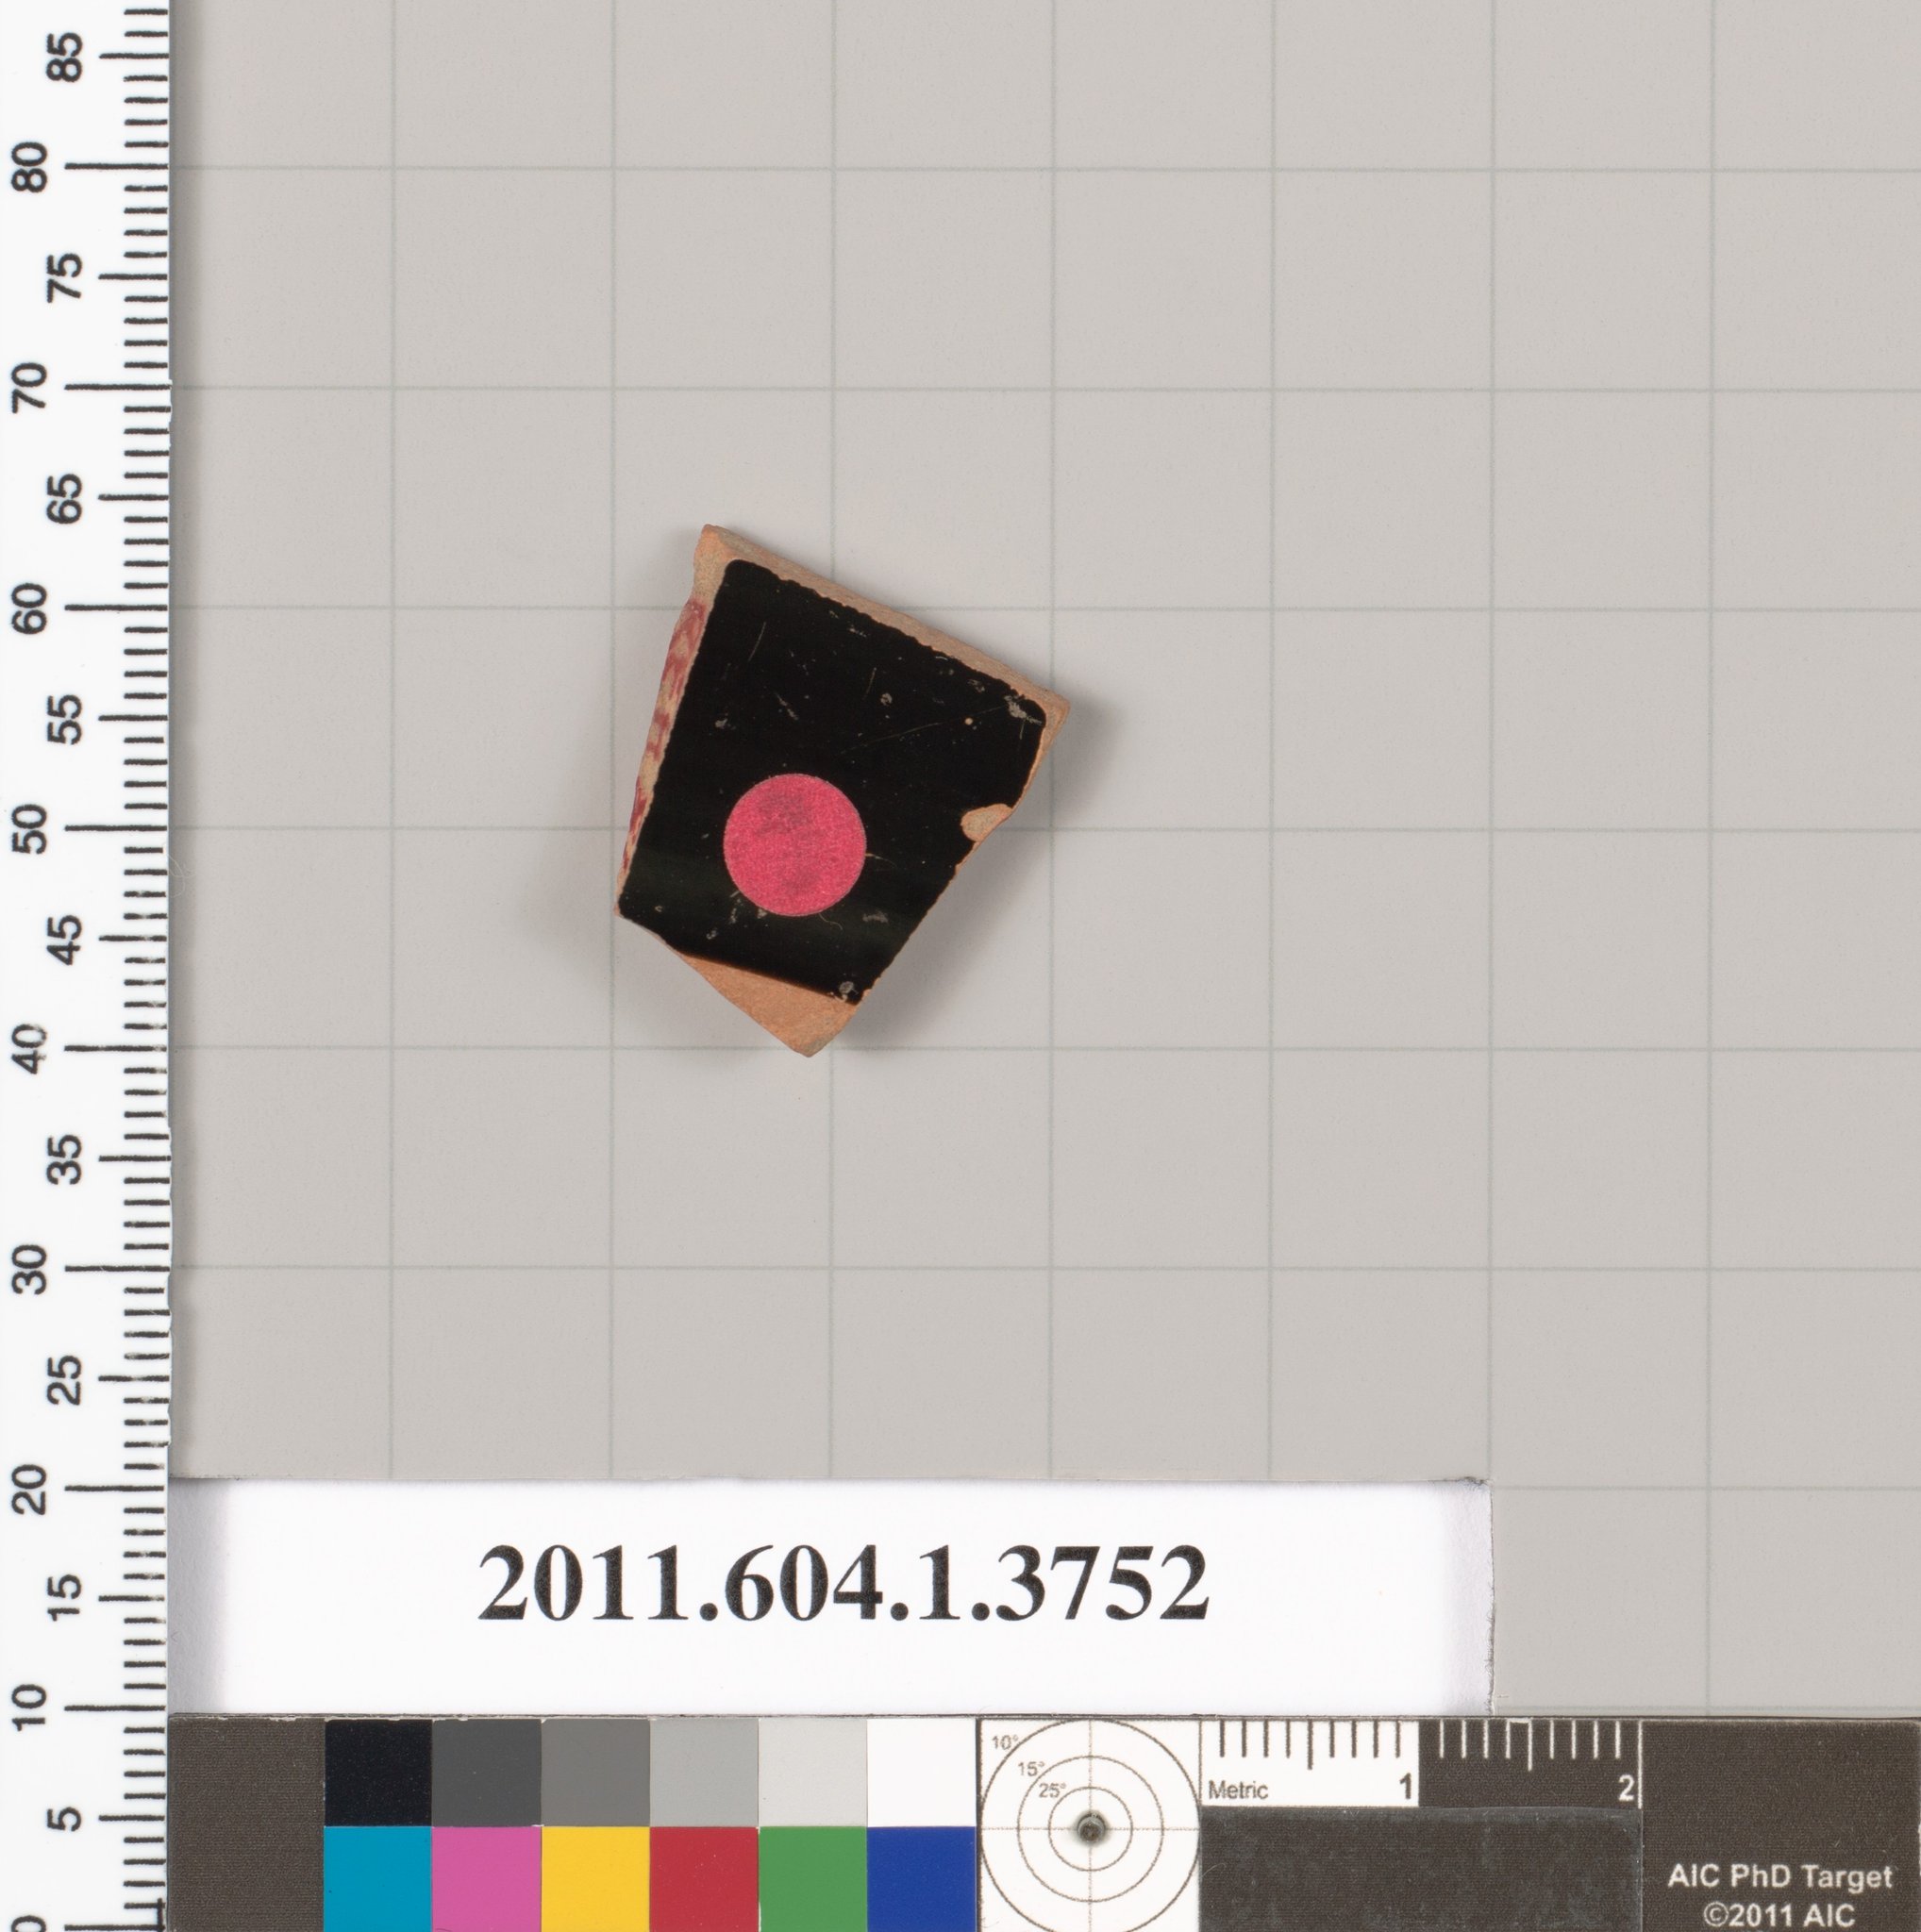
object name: kylix fragment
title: Terracotta fragment of a kylix (drinking cup)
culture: greek, attic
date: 500-470 BCE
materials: terracotta